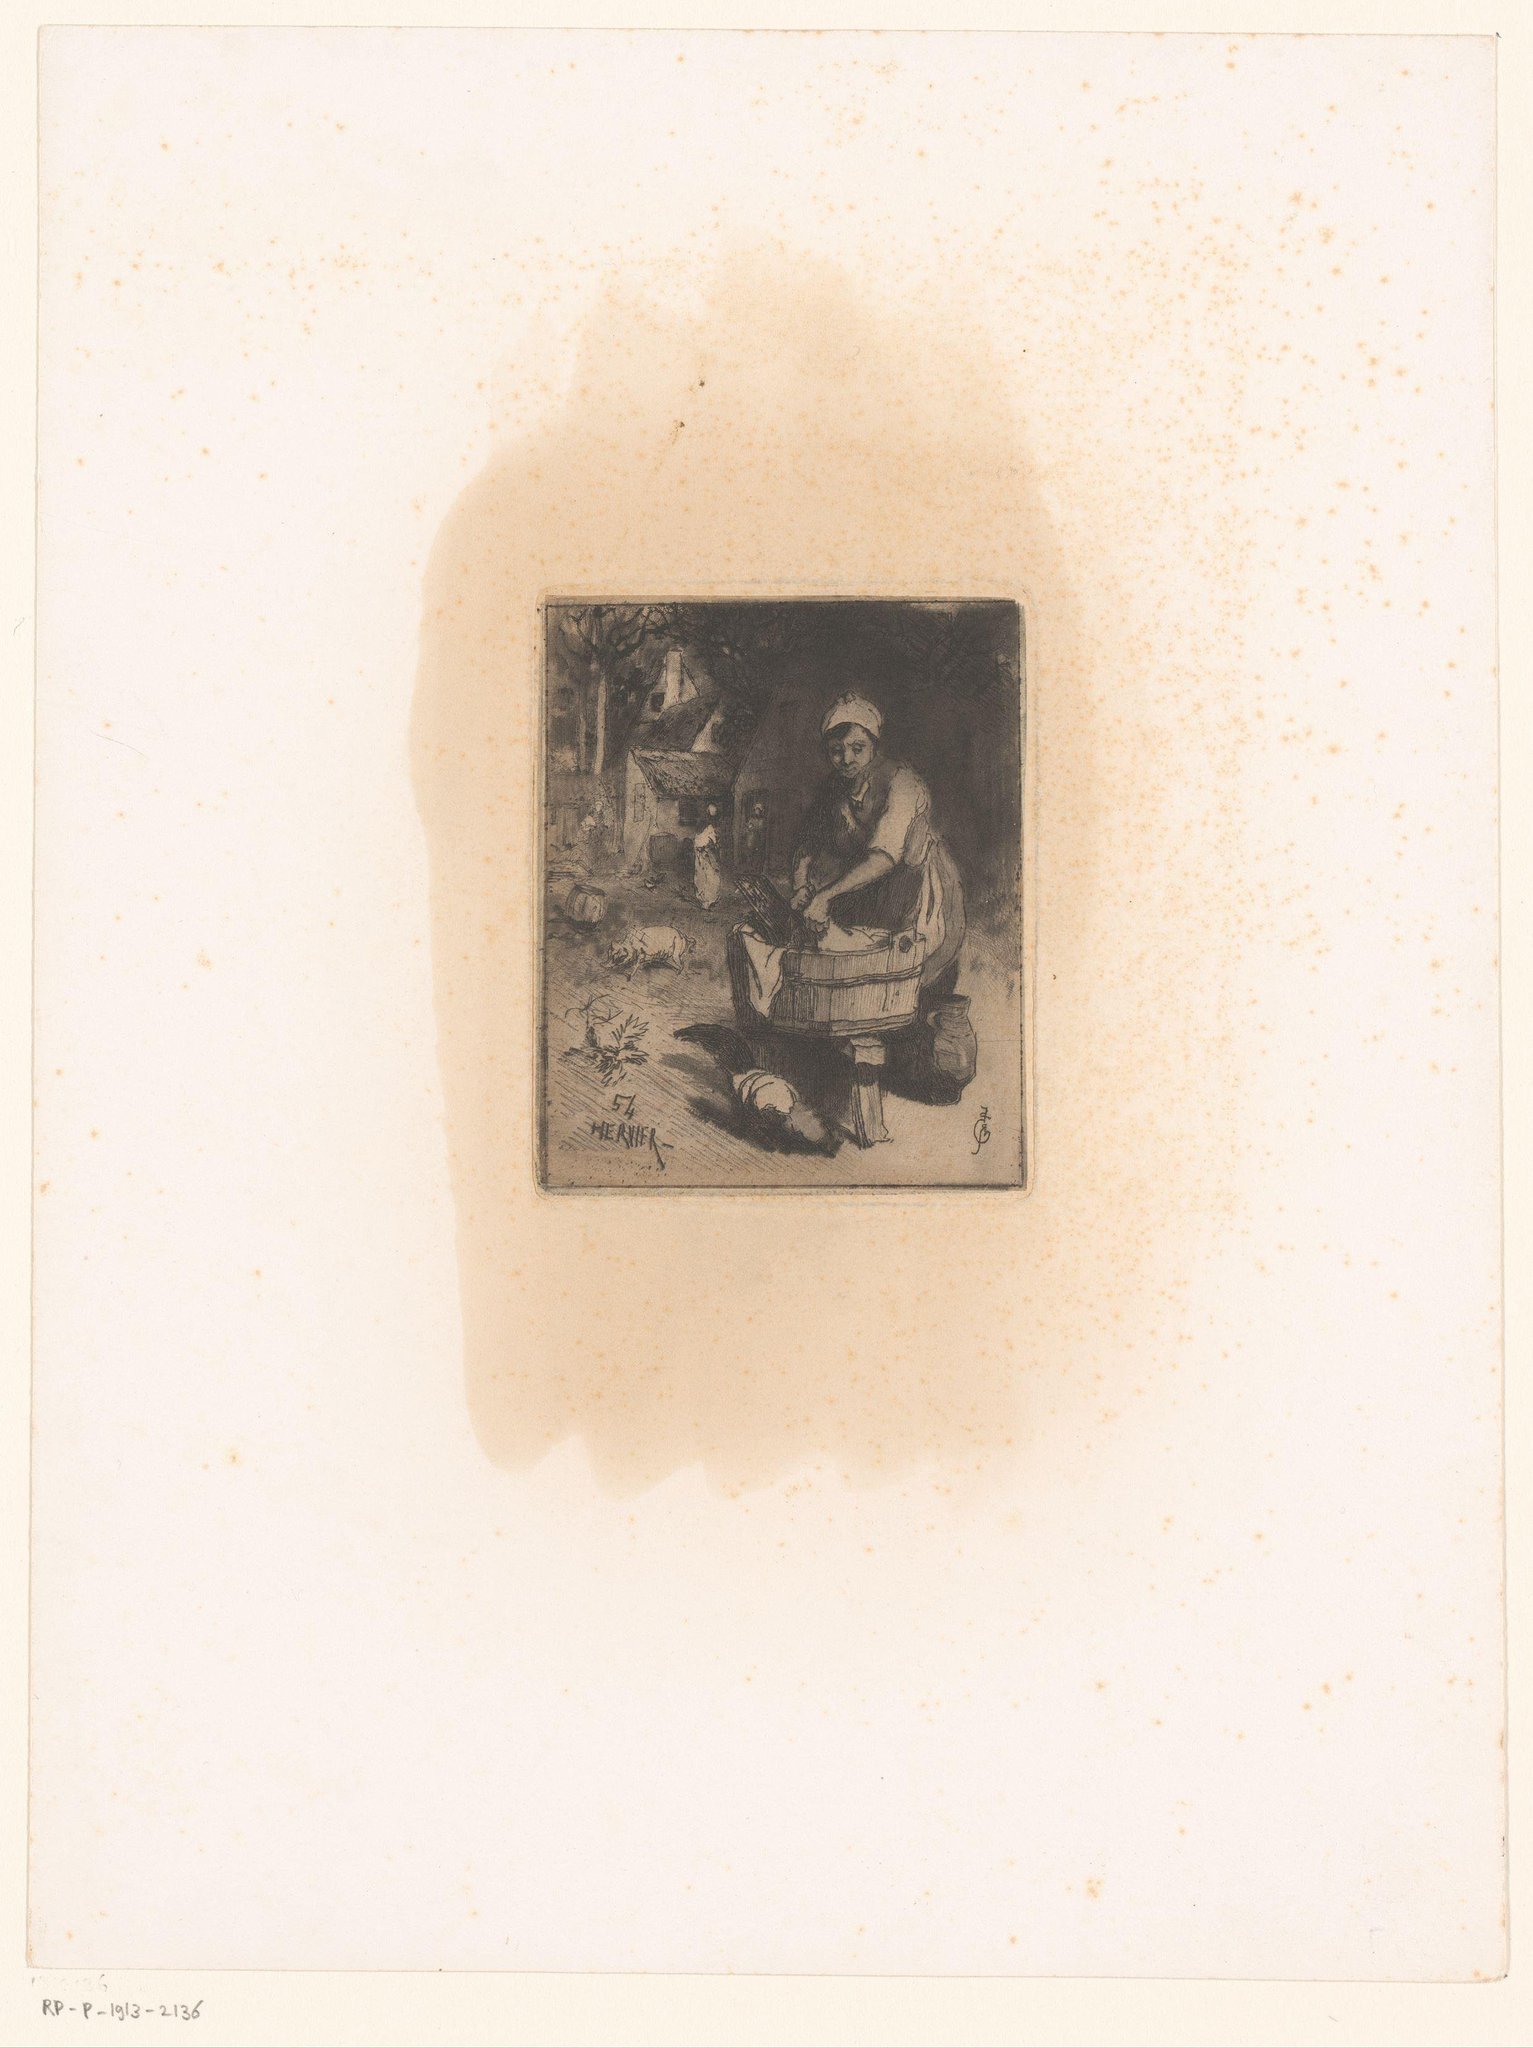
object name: print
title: Wasvrouw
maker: louis-adolphe hervier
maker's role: draughtsman, painter, print maker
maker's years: 1818-1879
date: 1854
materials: paper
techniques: etching, intaglio, roulette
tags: laundering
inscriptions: collector's mark: Lugt 2233